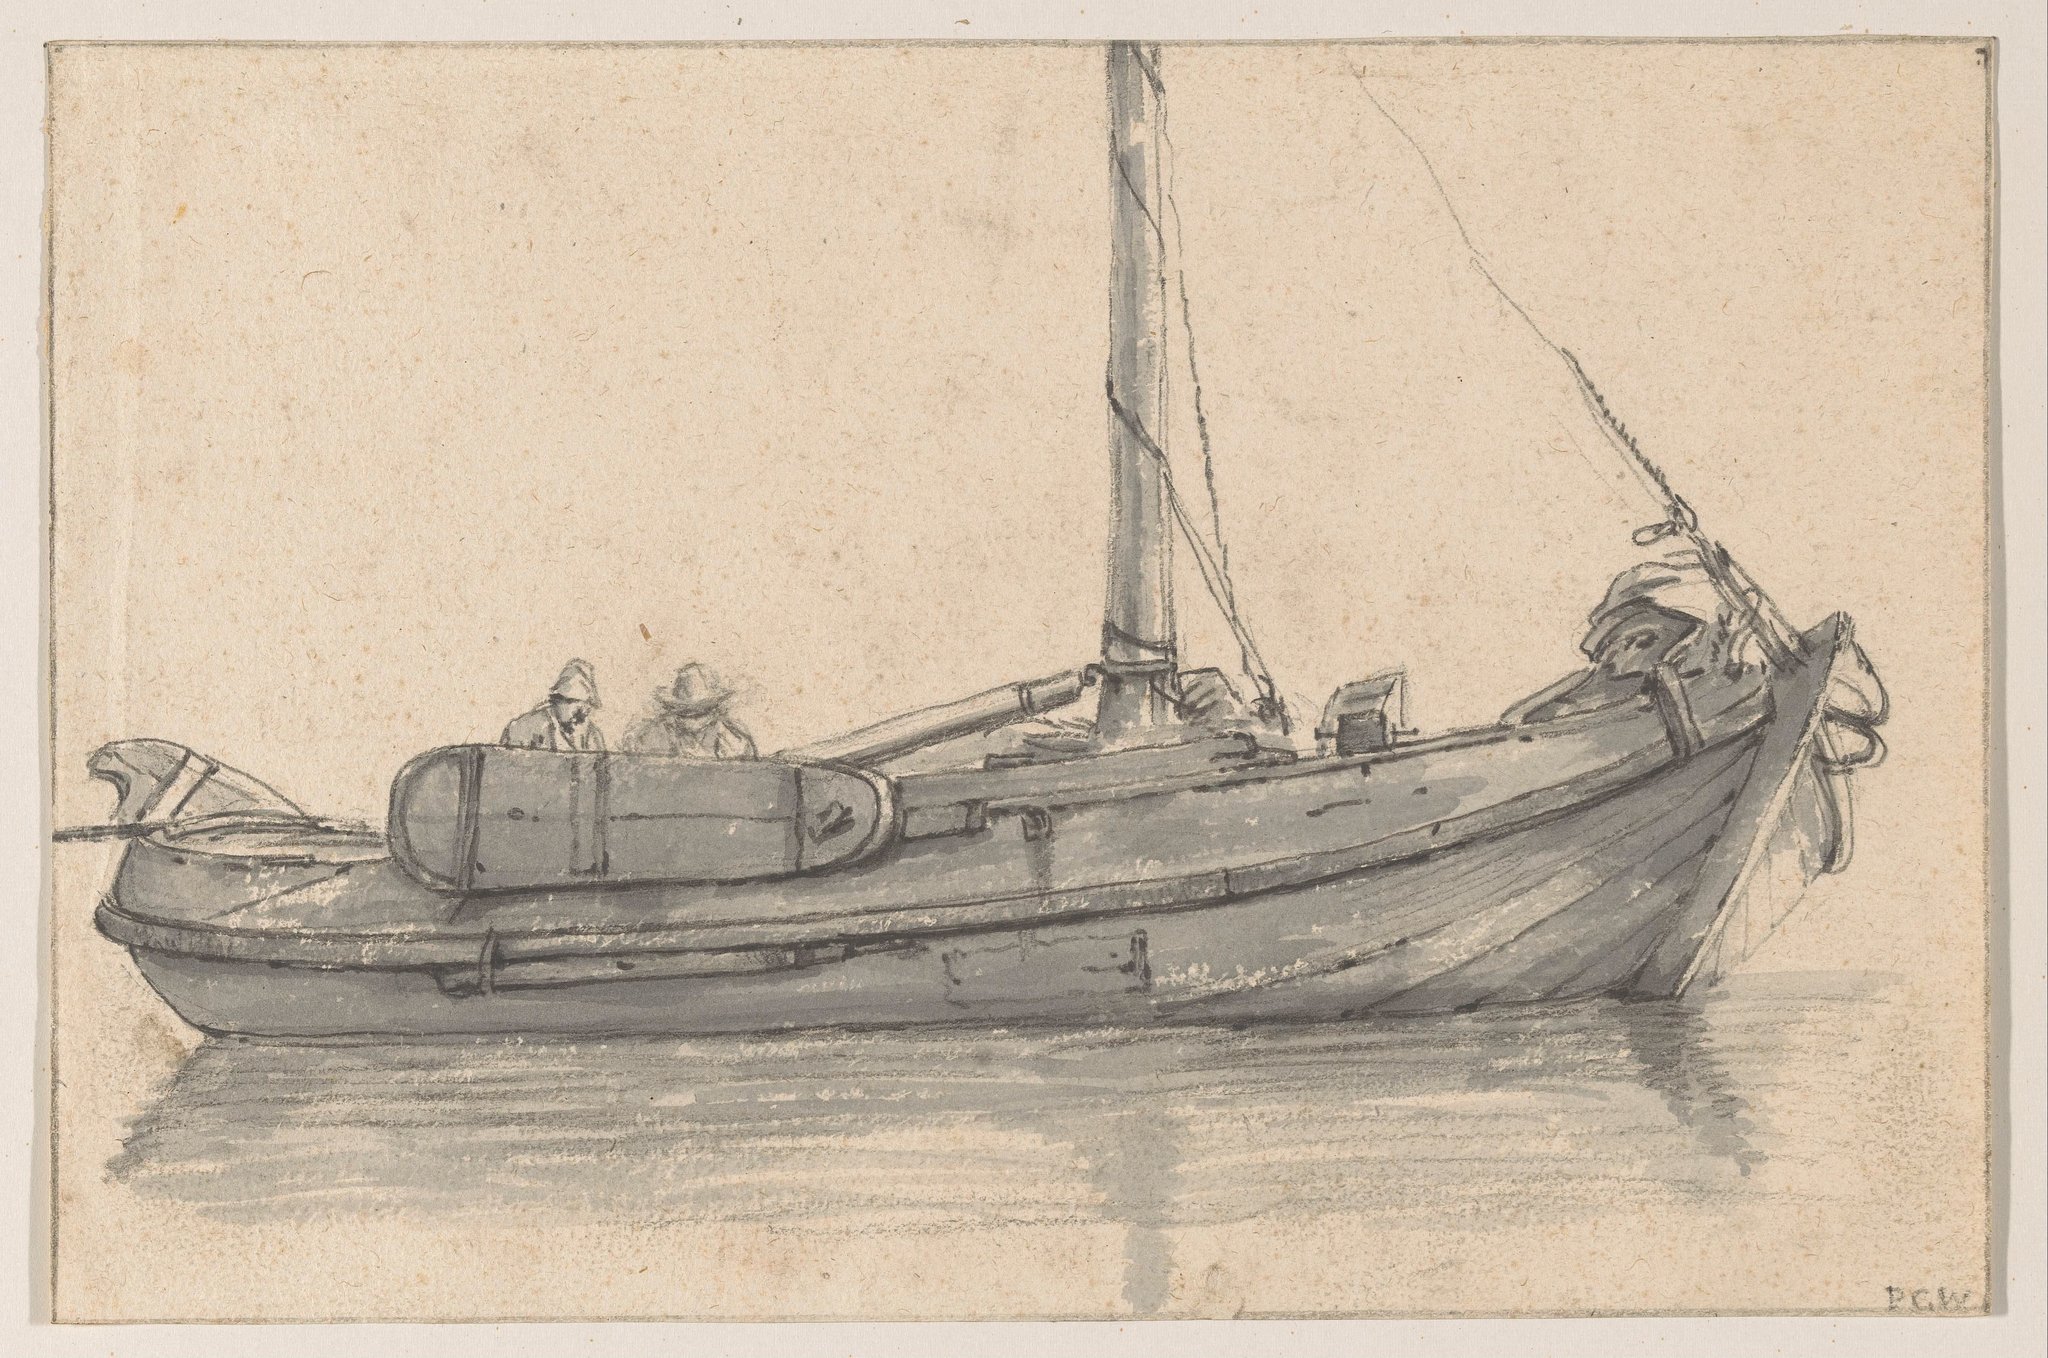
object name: drawing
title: Zeilschip op de zijde gezien, met op het schip twee mannen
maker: george pieter westenberg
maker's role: draughtsman, painter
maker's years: 1791-1873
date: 1801-1873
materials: chalk, paper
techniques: brush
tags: sailing-ship, sailing-boat